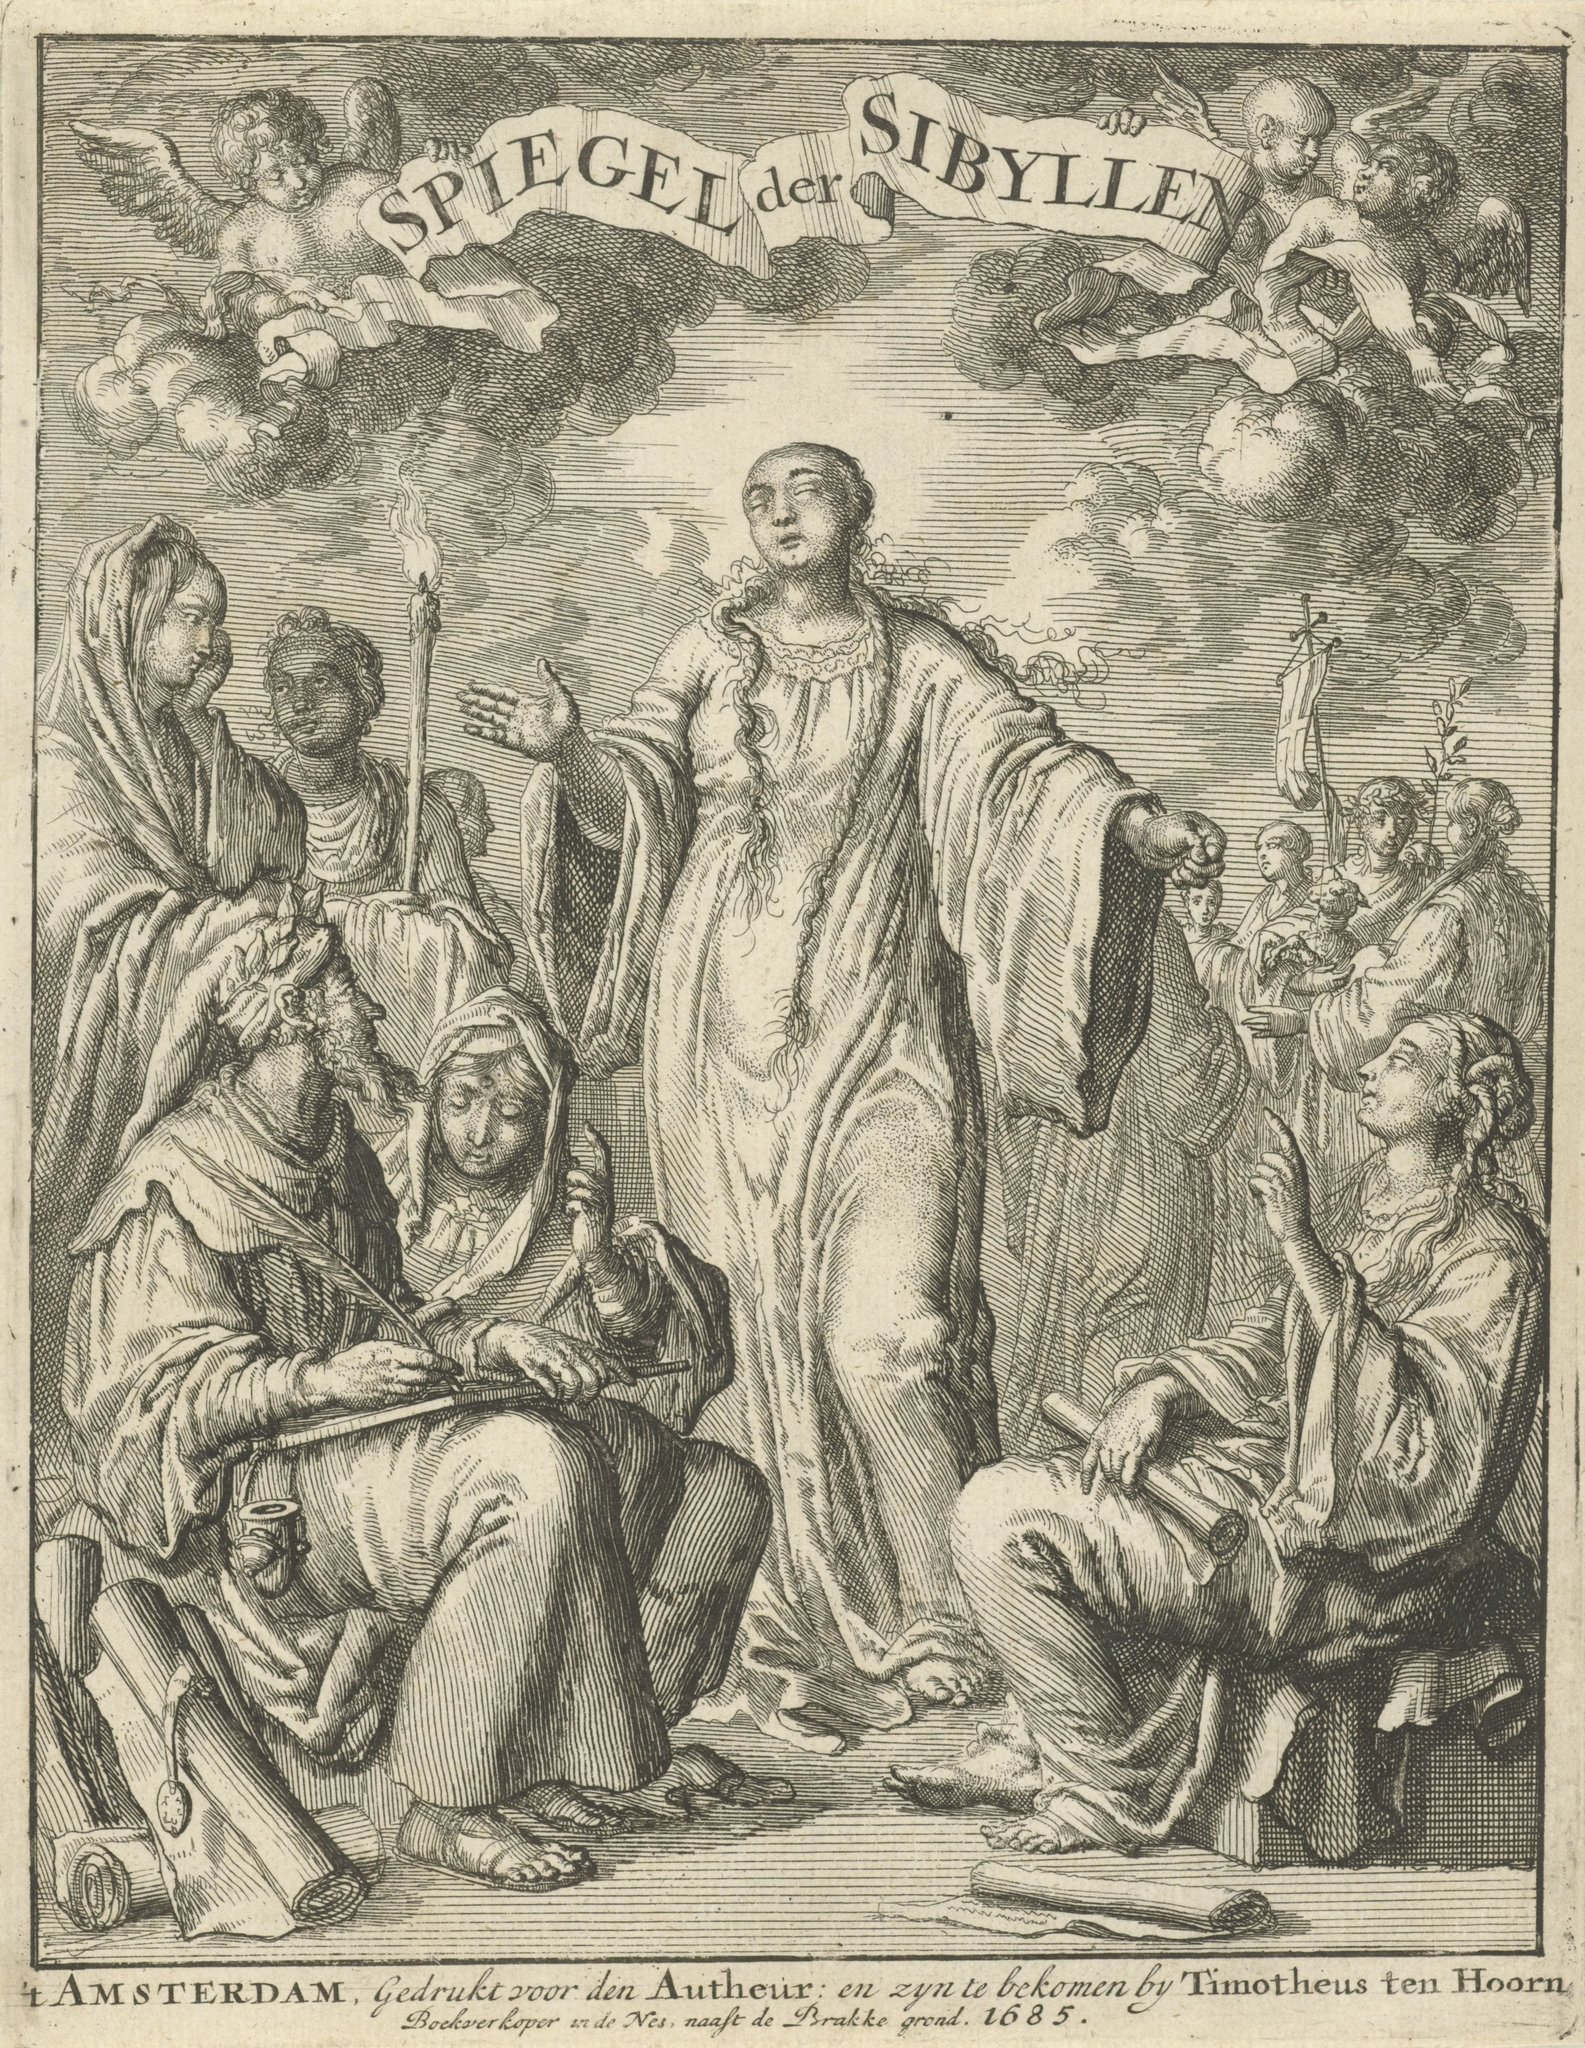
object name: print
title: Sibille omringd door toehoorders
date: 1684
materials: paper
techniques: etching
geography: amsterdam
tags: sibyls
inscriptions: collector's mark: Lugt 2228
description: Titelpagina voor: Aysma, Joannes. Spiegel der Sibyllen, van vierderley vertooningen. Amsterdam: Timotheus ten Hoorn, 1685.